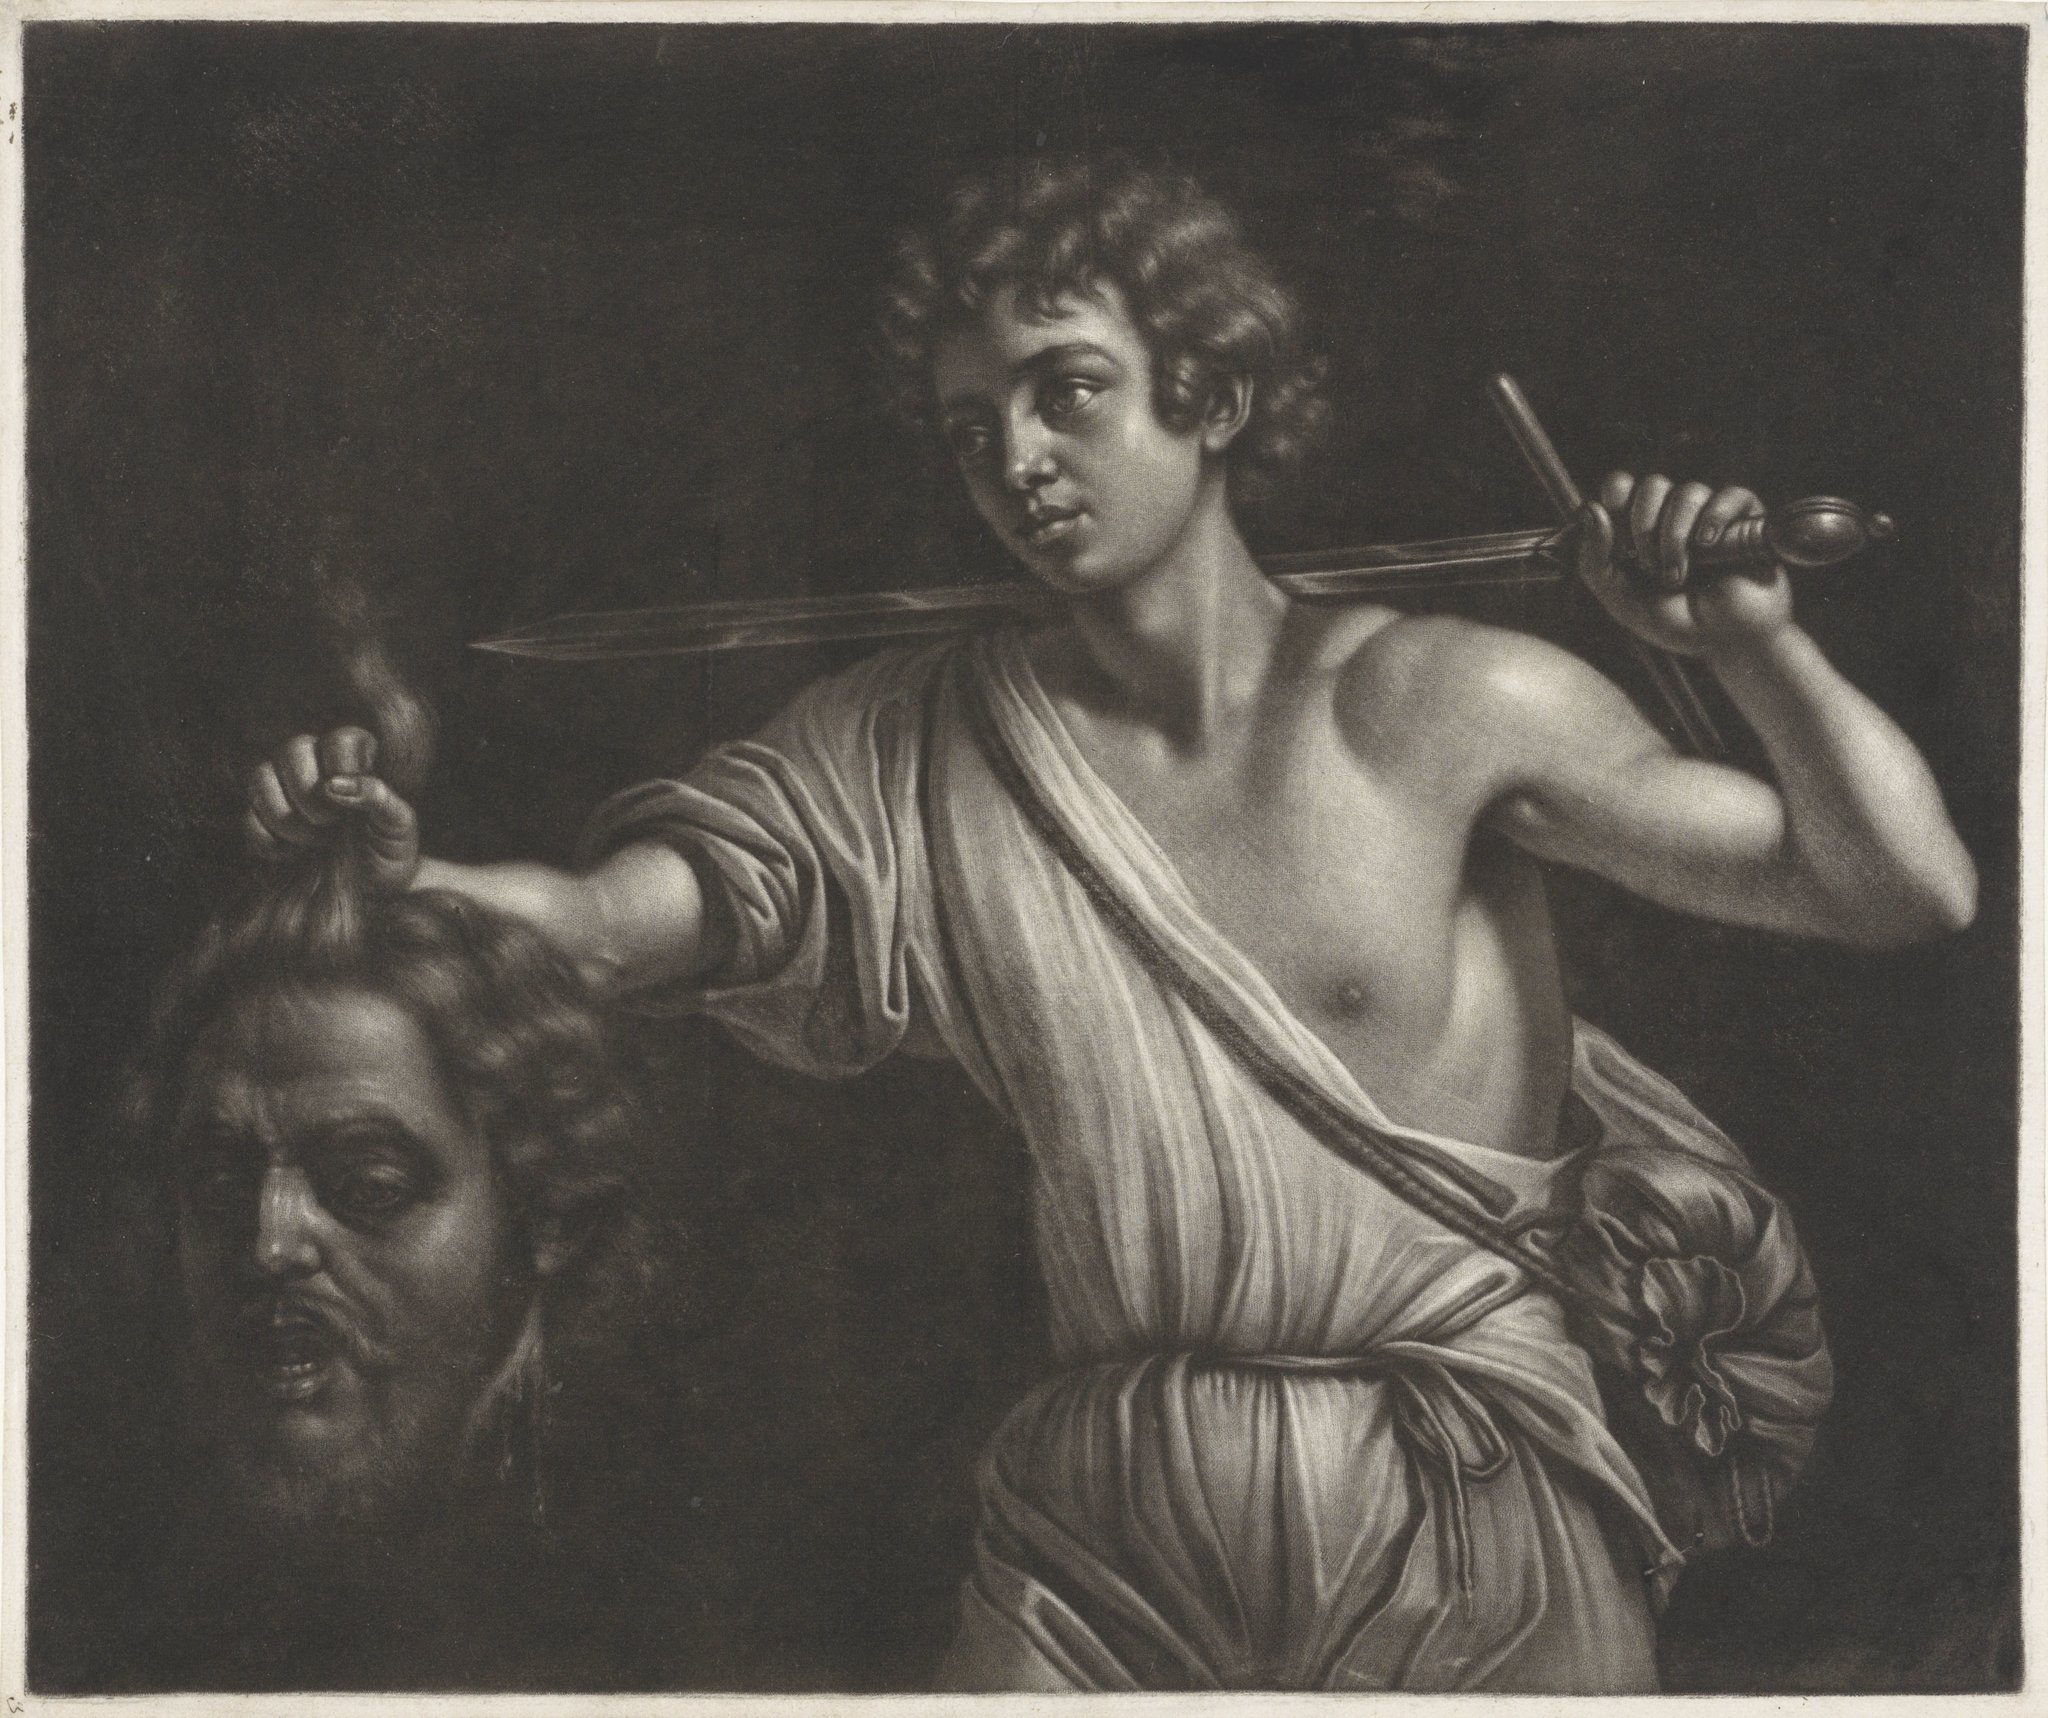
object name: print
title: David met het hoofd van Goliath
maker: wallerant vaillant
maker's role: draughtsman, painter, print maker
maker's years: 1623-1677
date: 1658-1677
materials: paper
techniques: mezzotint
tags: david with goliath's head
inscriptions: collector's mark: Lugt 10, collector's mark: Lugt 11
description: David heeft de reus Goliath overwonnen en houdt diens hoofd aan zijn haren omhoog. In zijn andere hand heeft hij zijn zwaard.